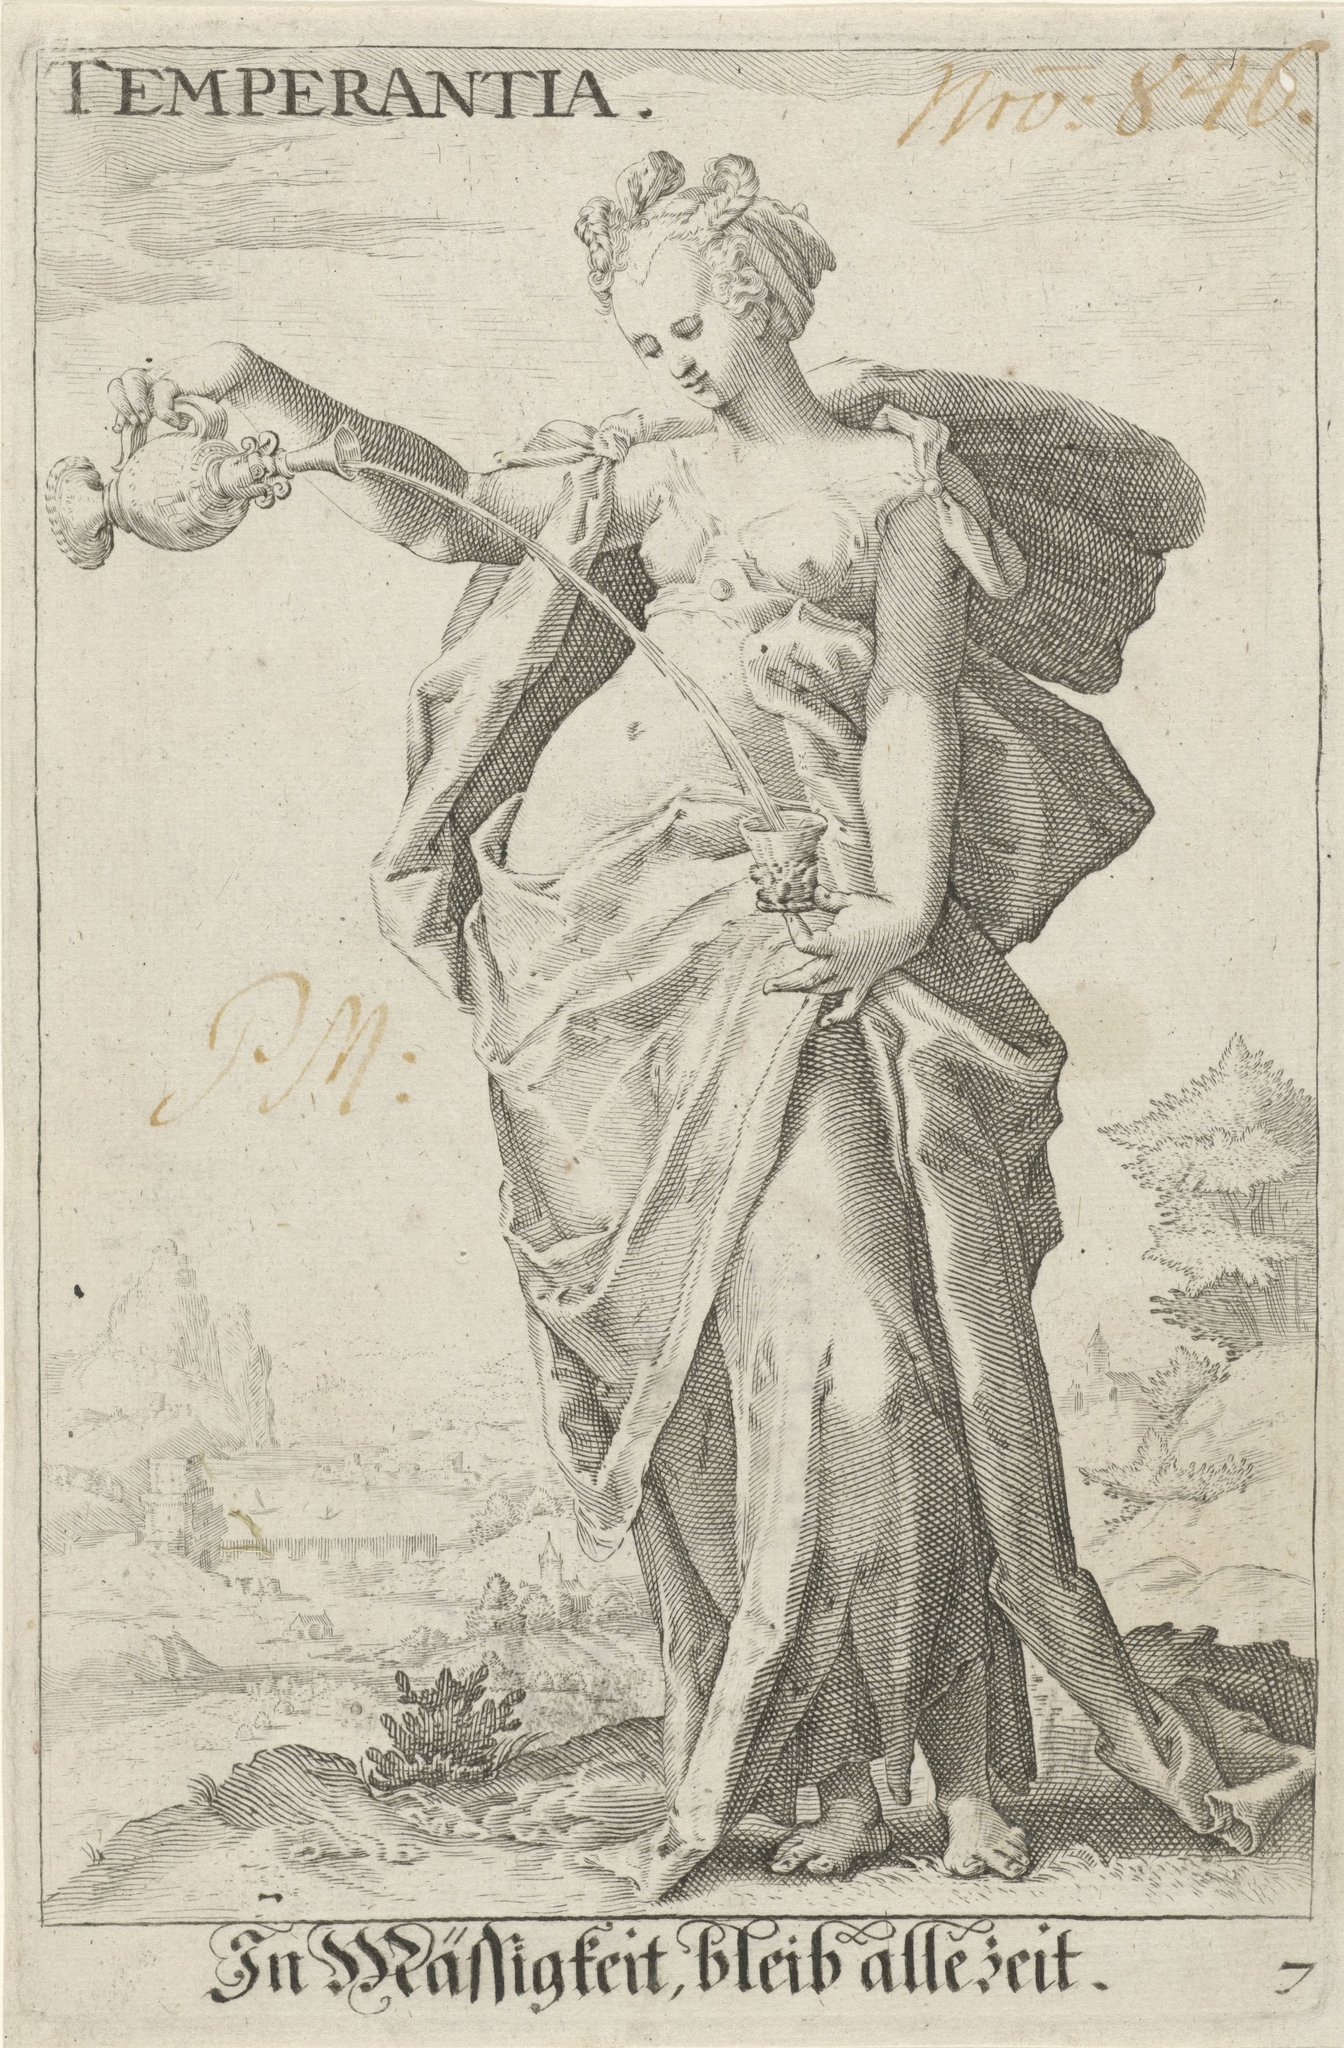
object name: print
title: Matigheid (Temperantia)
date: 1587-1637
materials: paper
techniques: engraving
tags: temperance, 'temperantia'; 'temperanza' (ripa) ~ one of the four cardinal virtues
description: De gepersonifieerde Matigheid; een vrouwenfiguur giet uit een kan vloeistof in een glaasje. Op de achtergrond een heuvelachtig rivierlandschap.